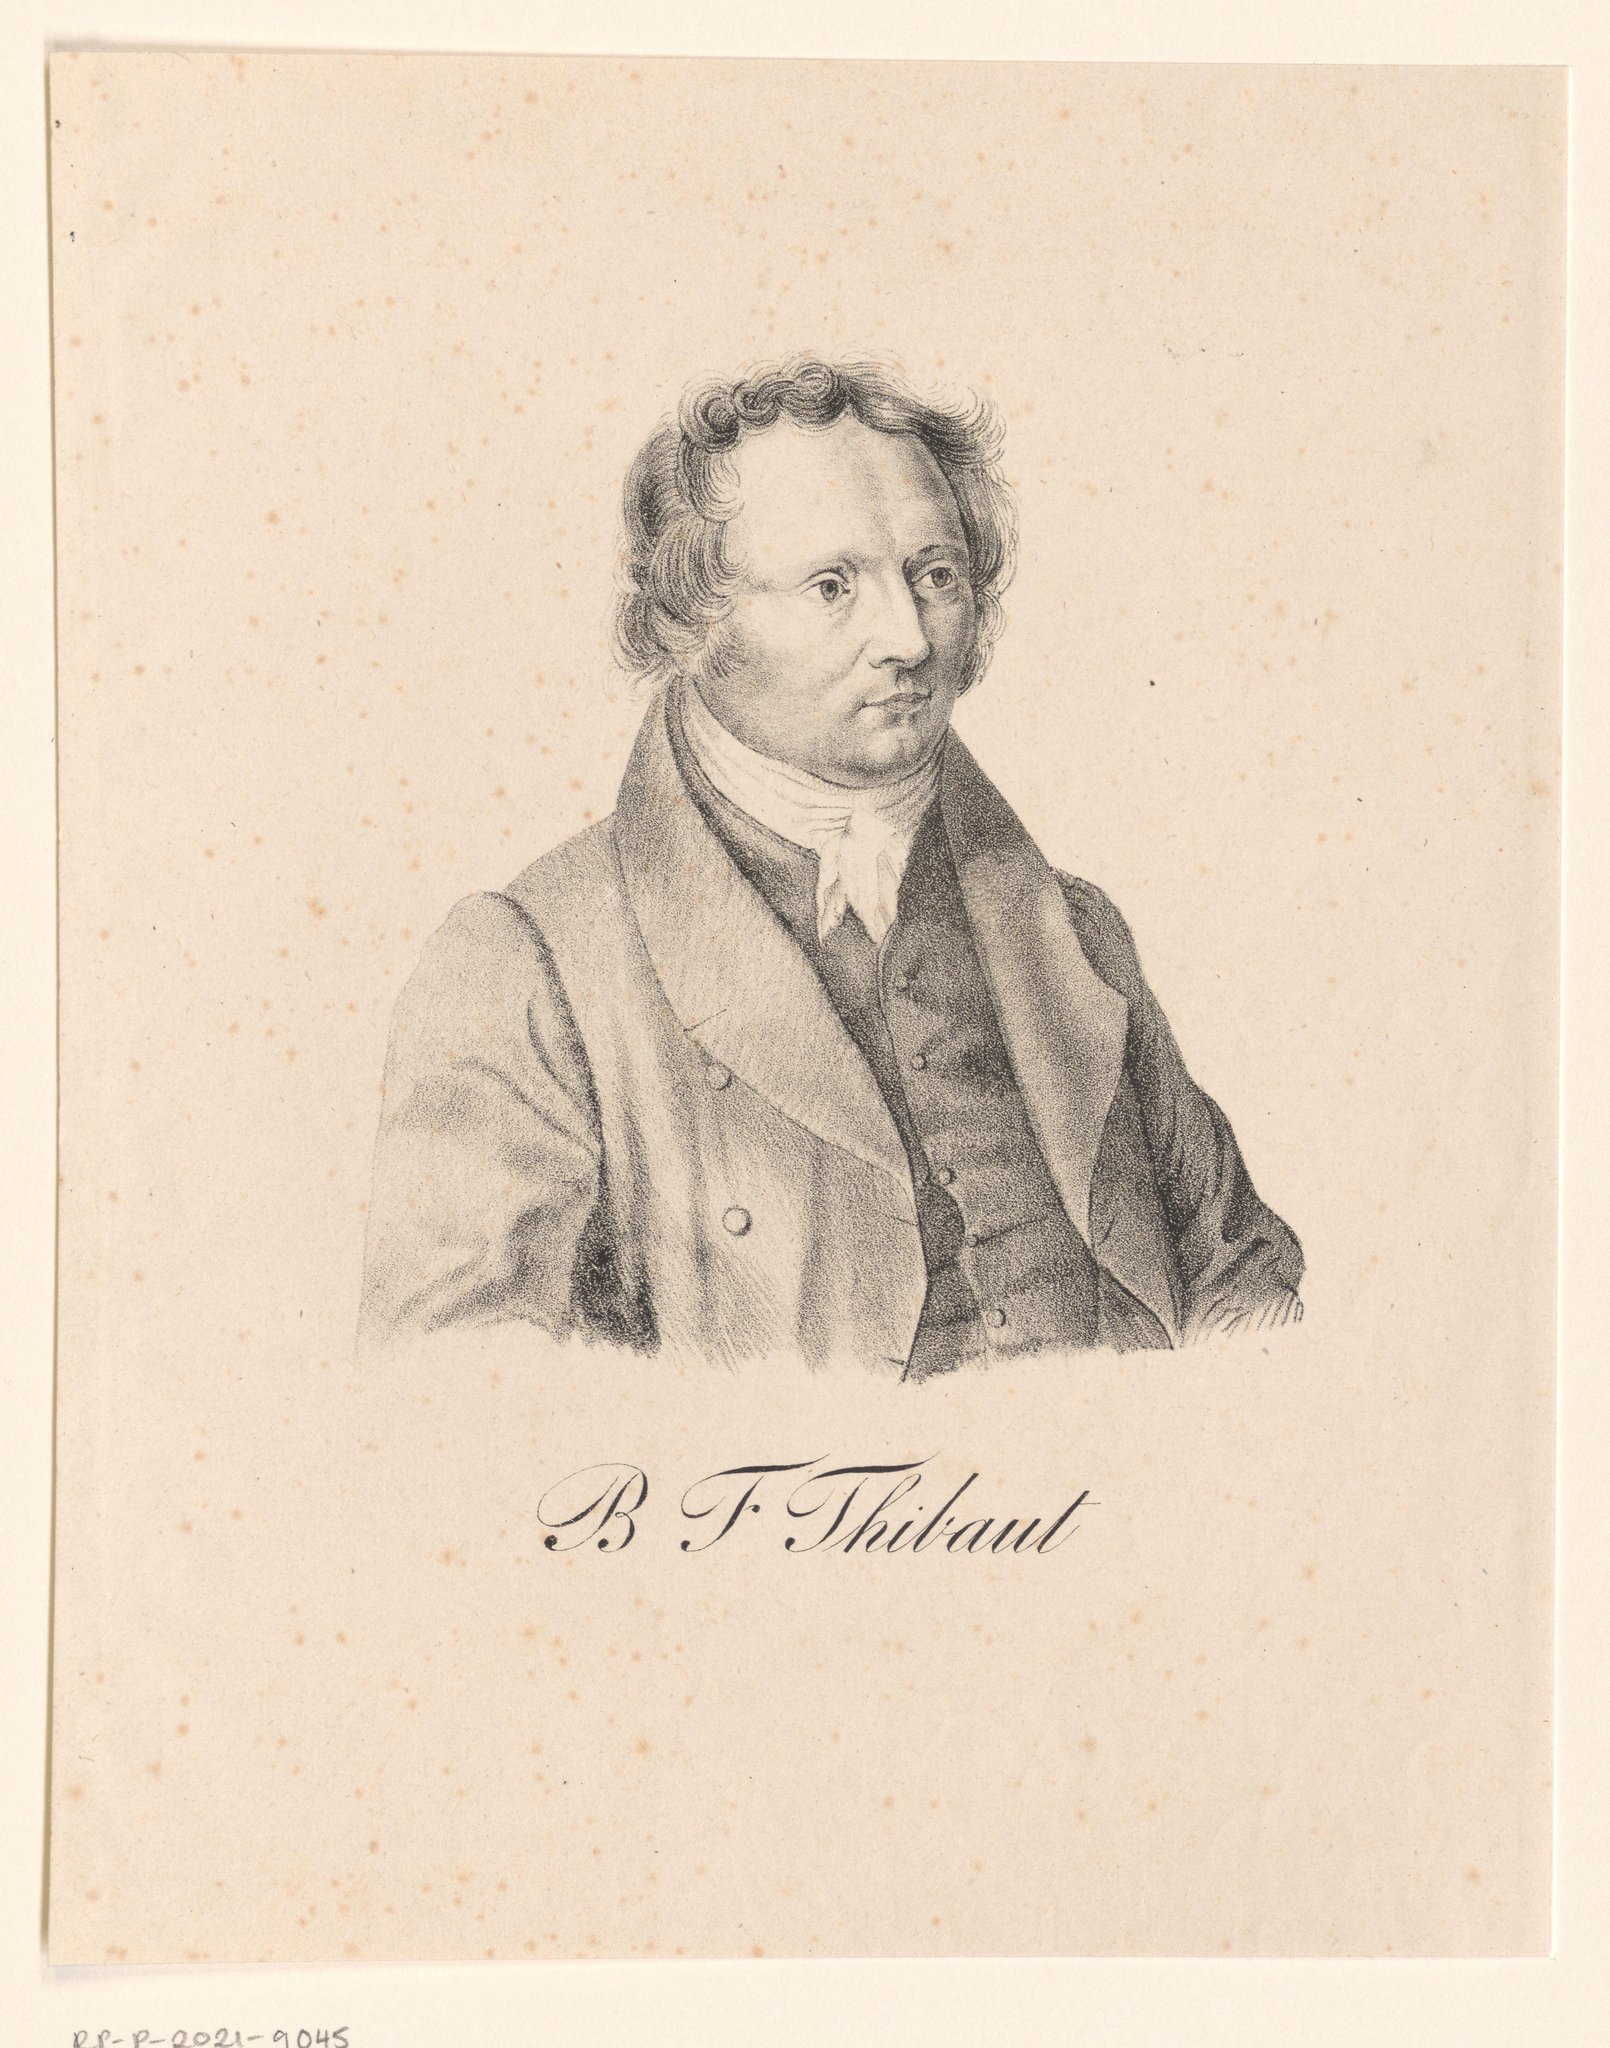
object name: print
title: Portret van Bernhard Friedrich Thibaut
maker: Anonymous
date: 1825-1849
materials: paper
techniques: lithograph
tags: historical persons, mathematics (+ portrait of scholar, scientist)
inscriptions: collector's mark: Lugt 2228